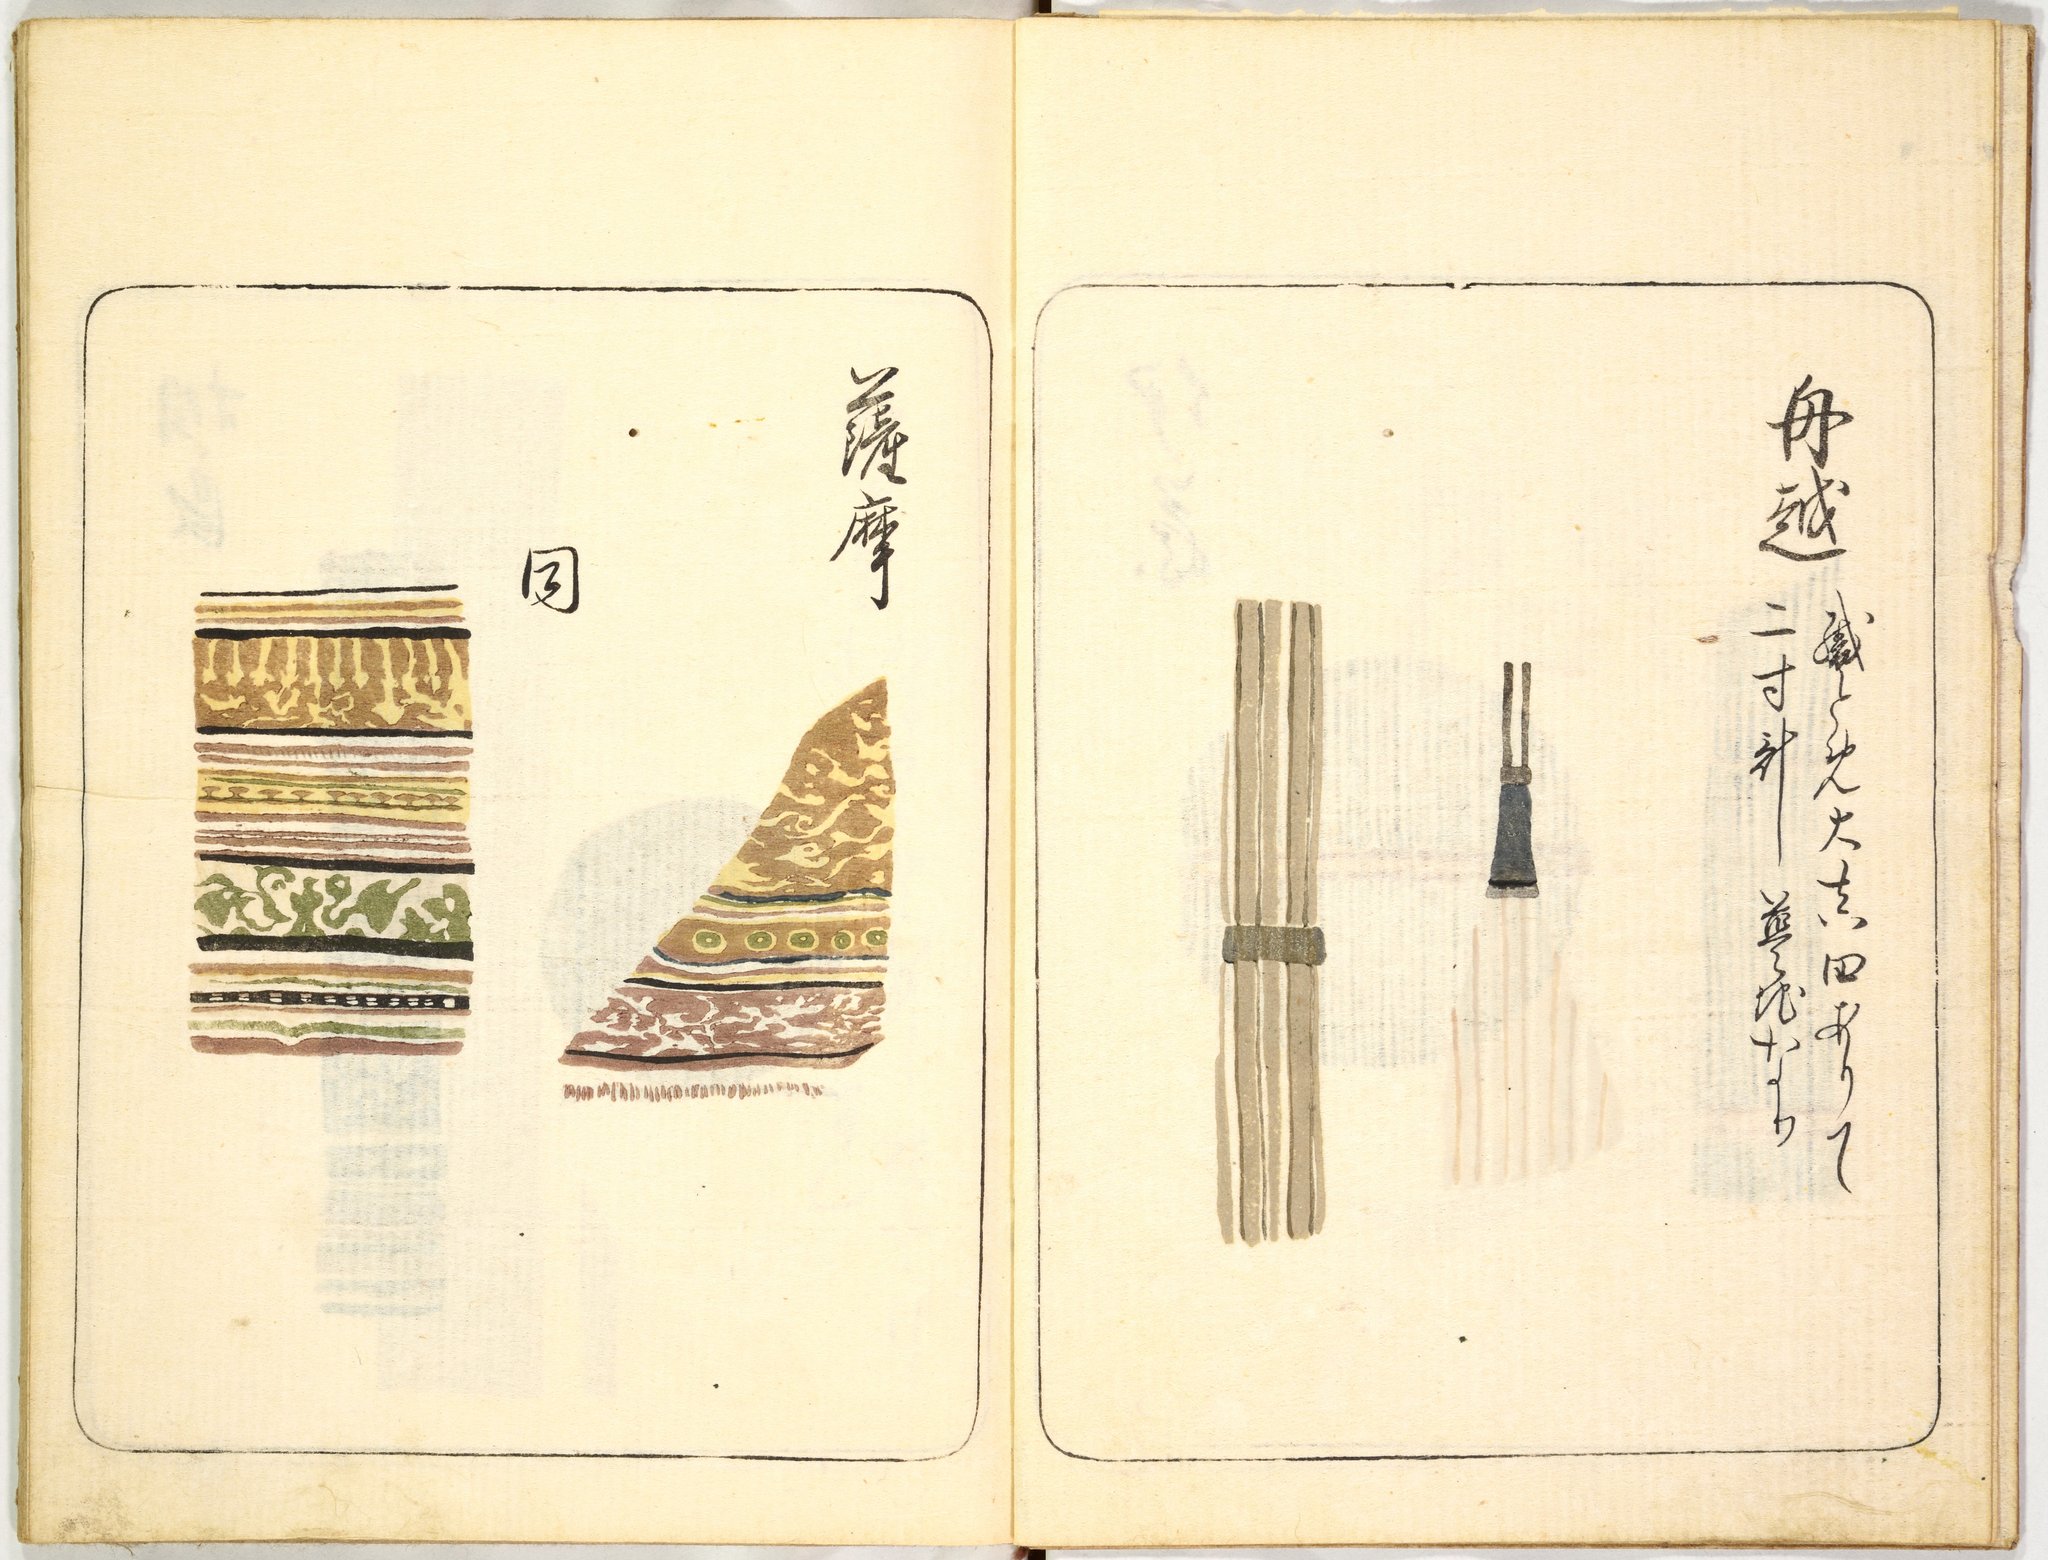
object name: illustrated book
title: Kokon meibutsu rui shū, Vol. 2 (examples of old textile designs)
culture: japanese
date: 1789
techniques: woodblock print